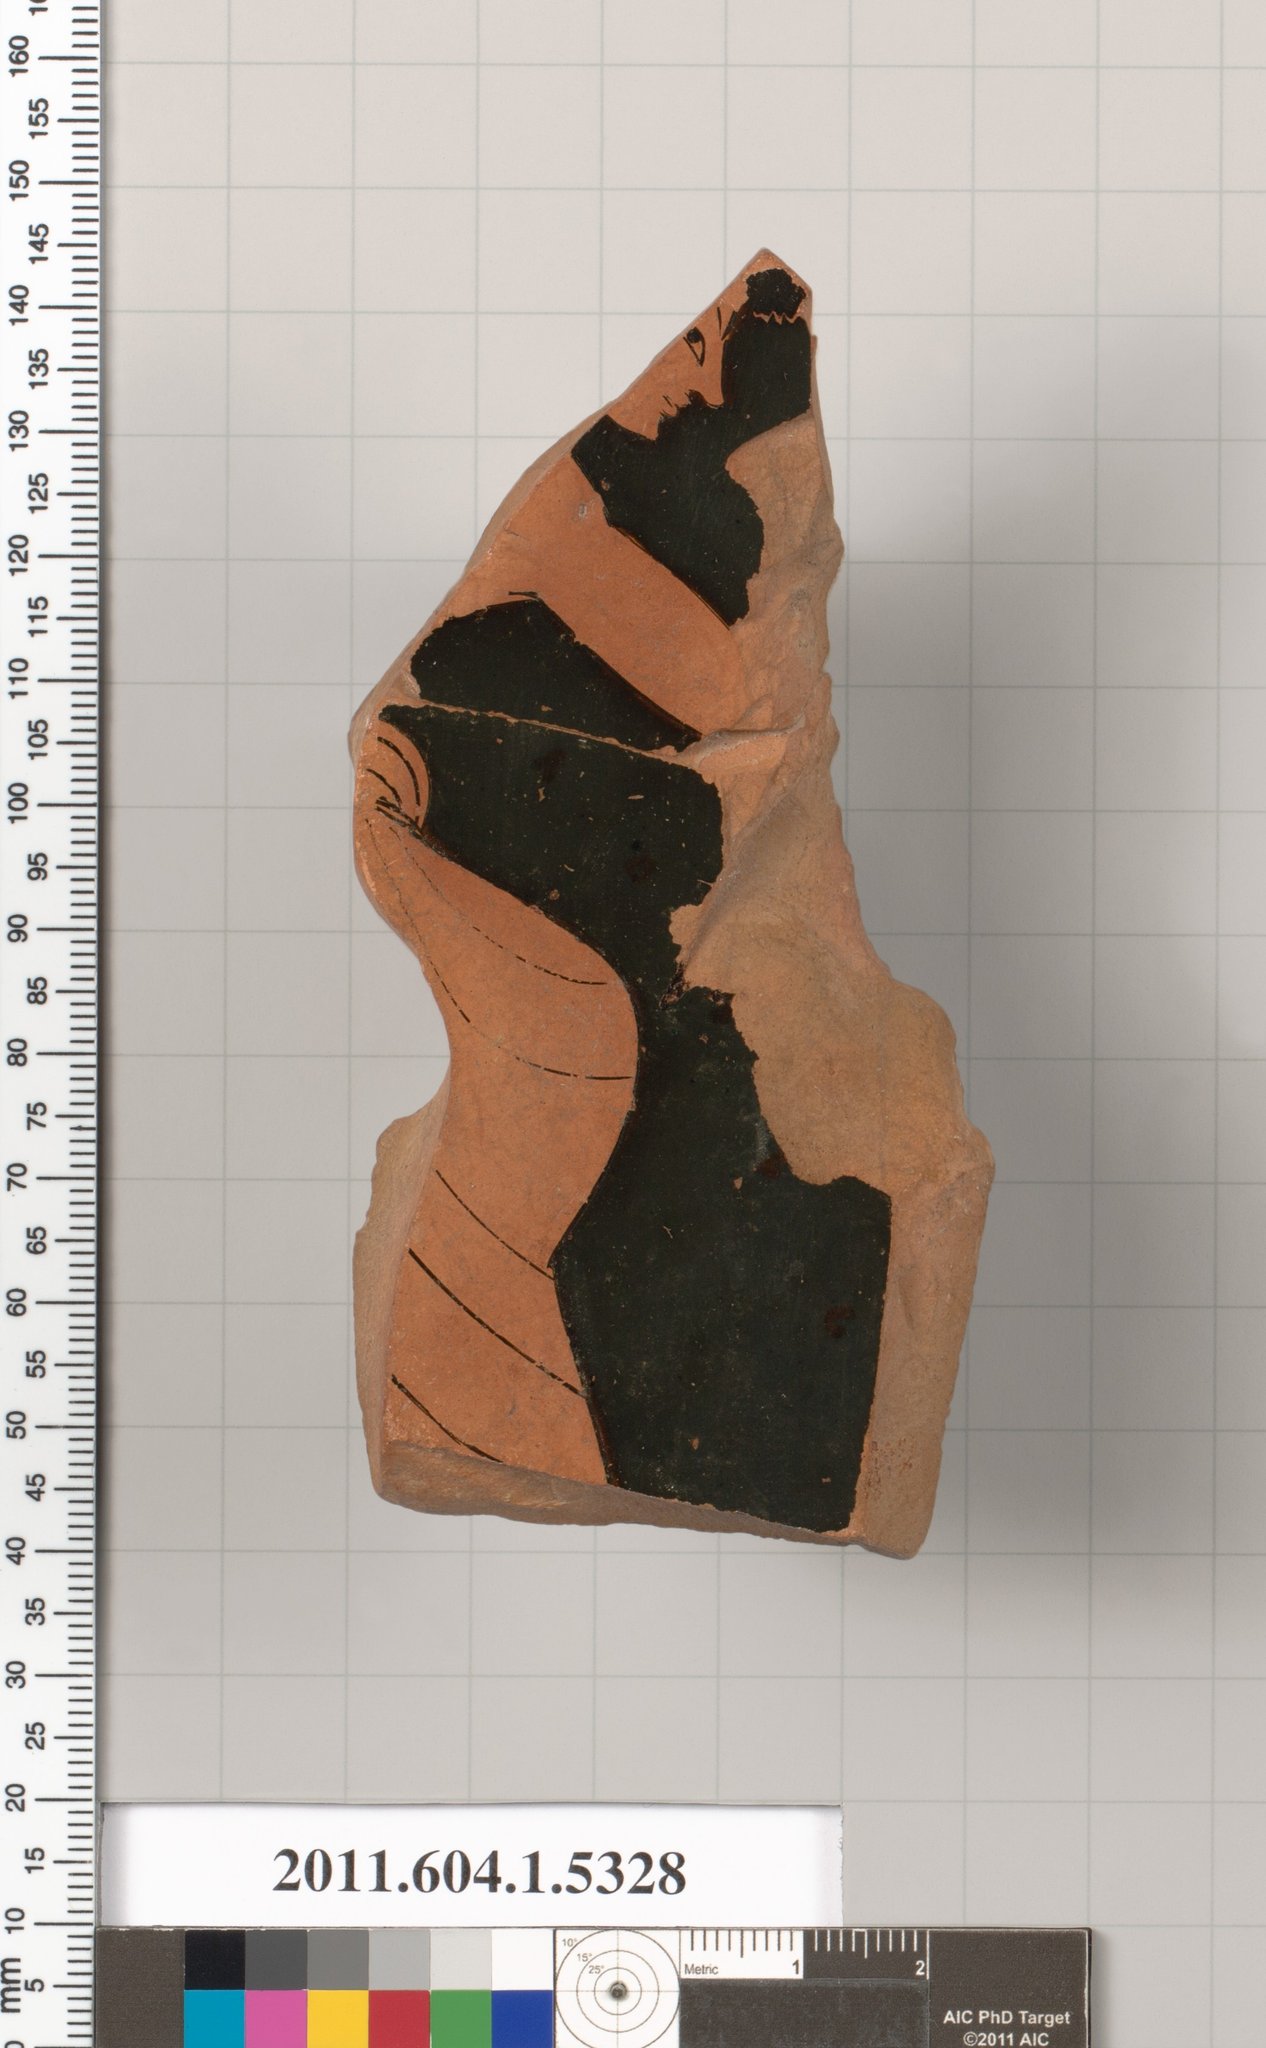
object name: kylix fragment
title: Terracotta fragment of a kylix (drinking cup)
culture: greek, attic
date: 520-510 BCE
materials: terracotta